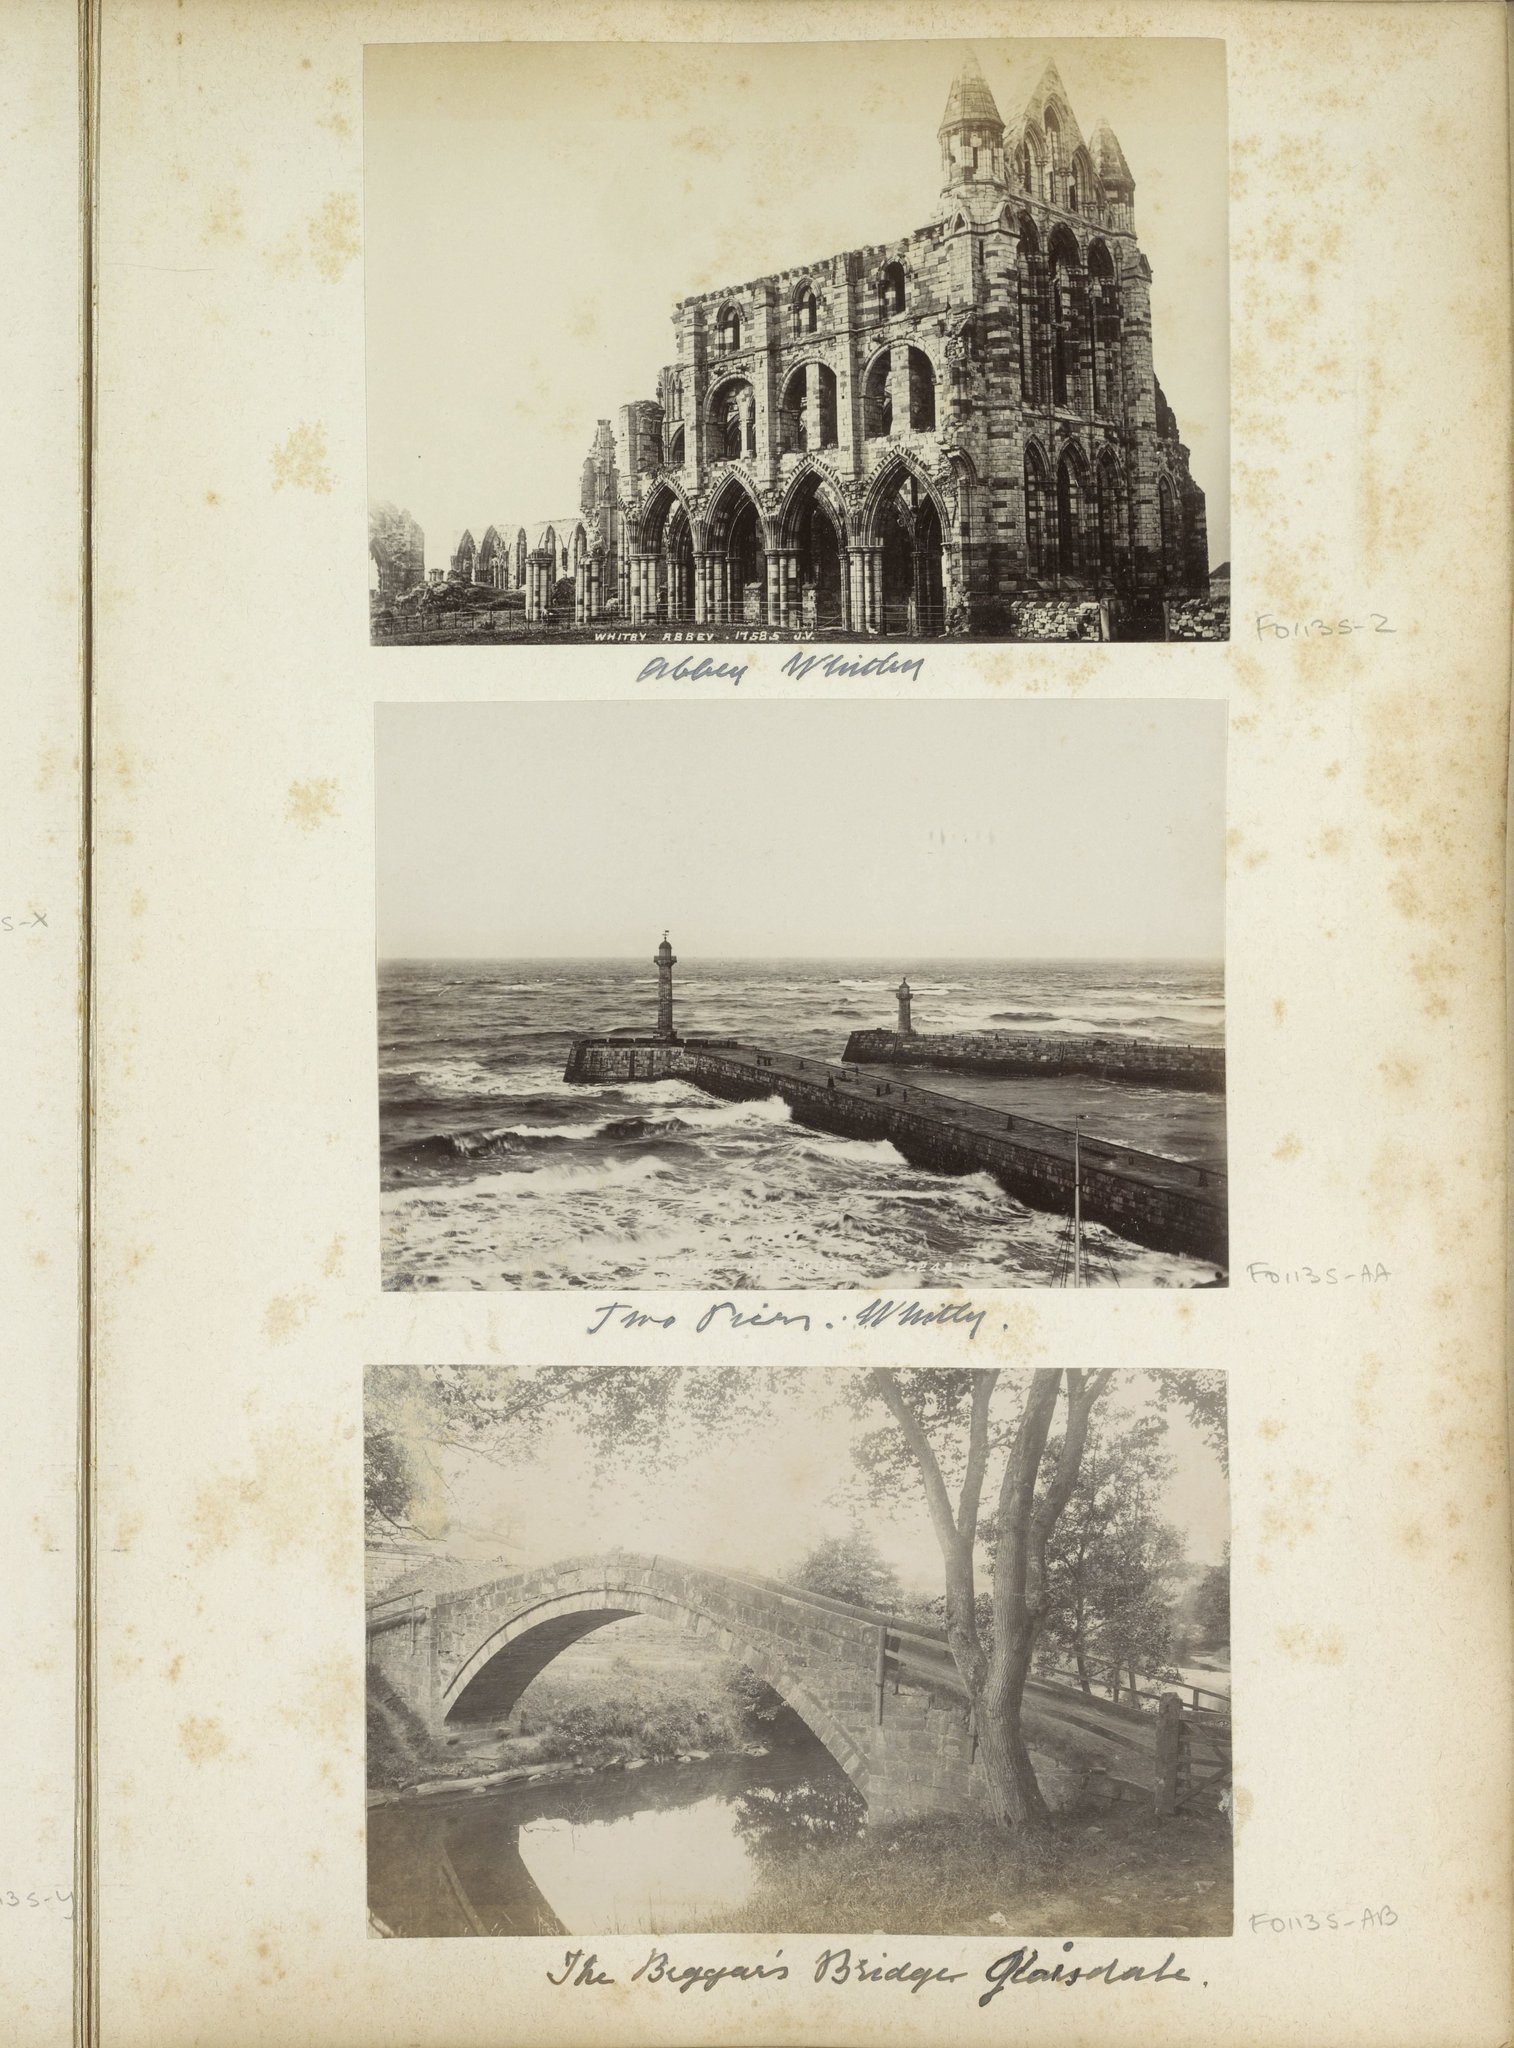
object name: album leaf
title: Gezicht op de haveningang van Whitby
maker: Anonymous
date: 1898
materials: paper, photographic support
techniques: albumen print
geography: whitby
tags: harbour, lighthouse, lightship, pier, quay, wharf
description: Onderdeel van Reisalbum met foto's van bezienswaardigheden in Engeland en Frankrijk.